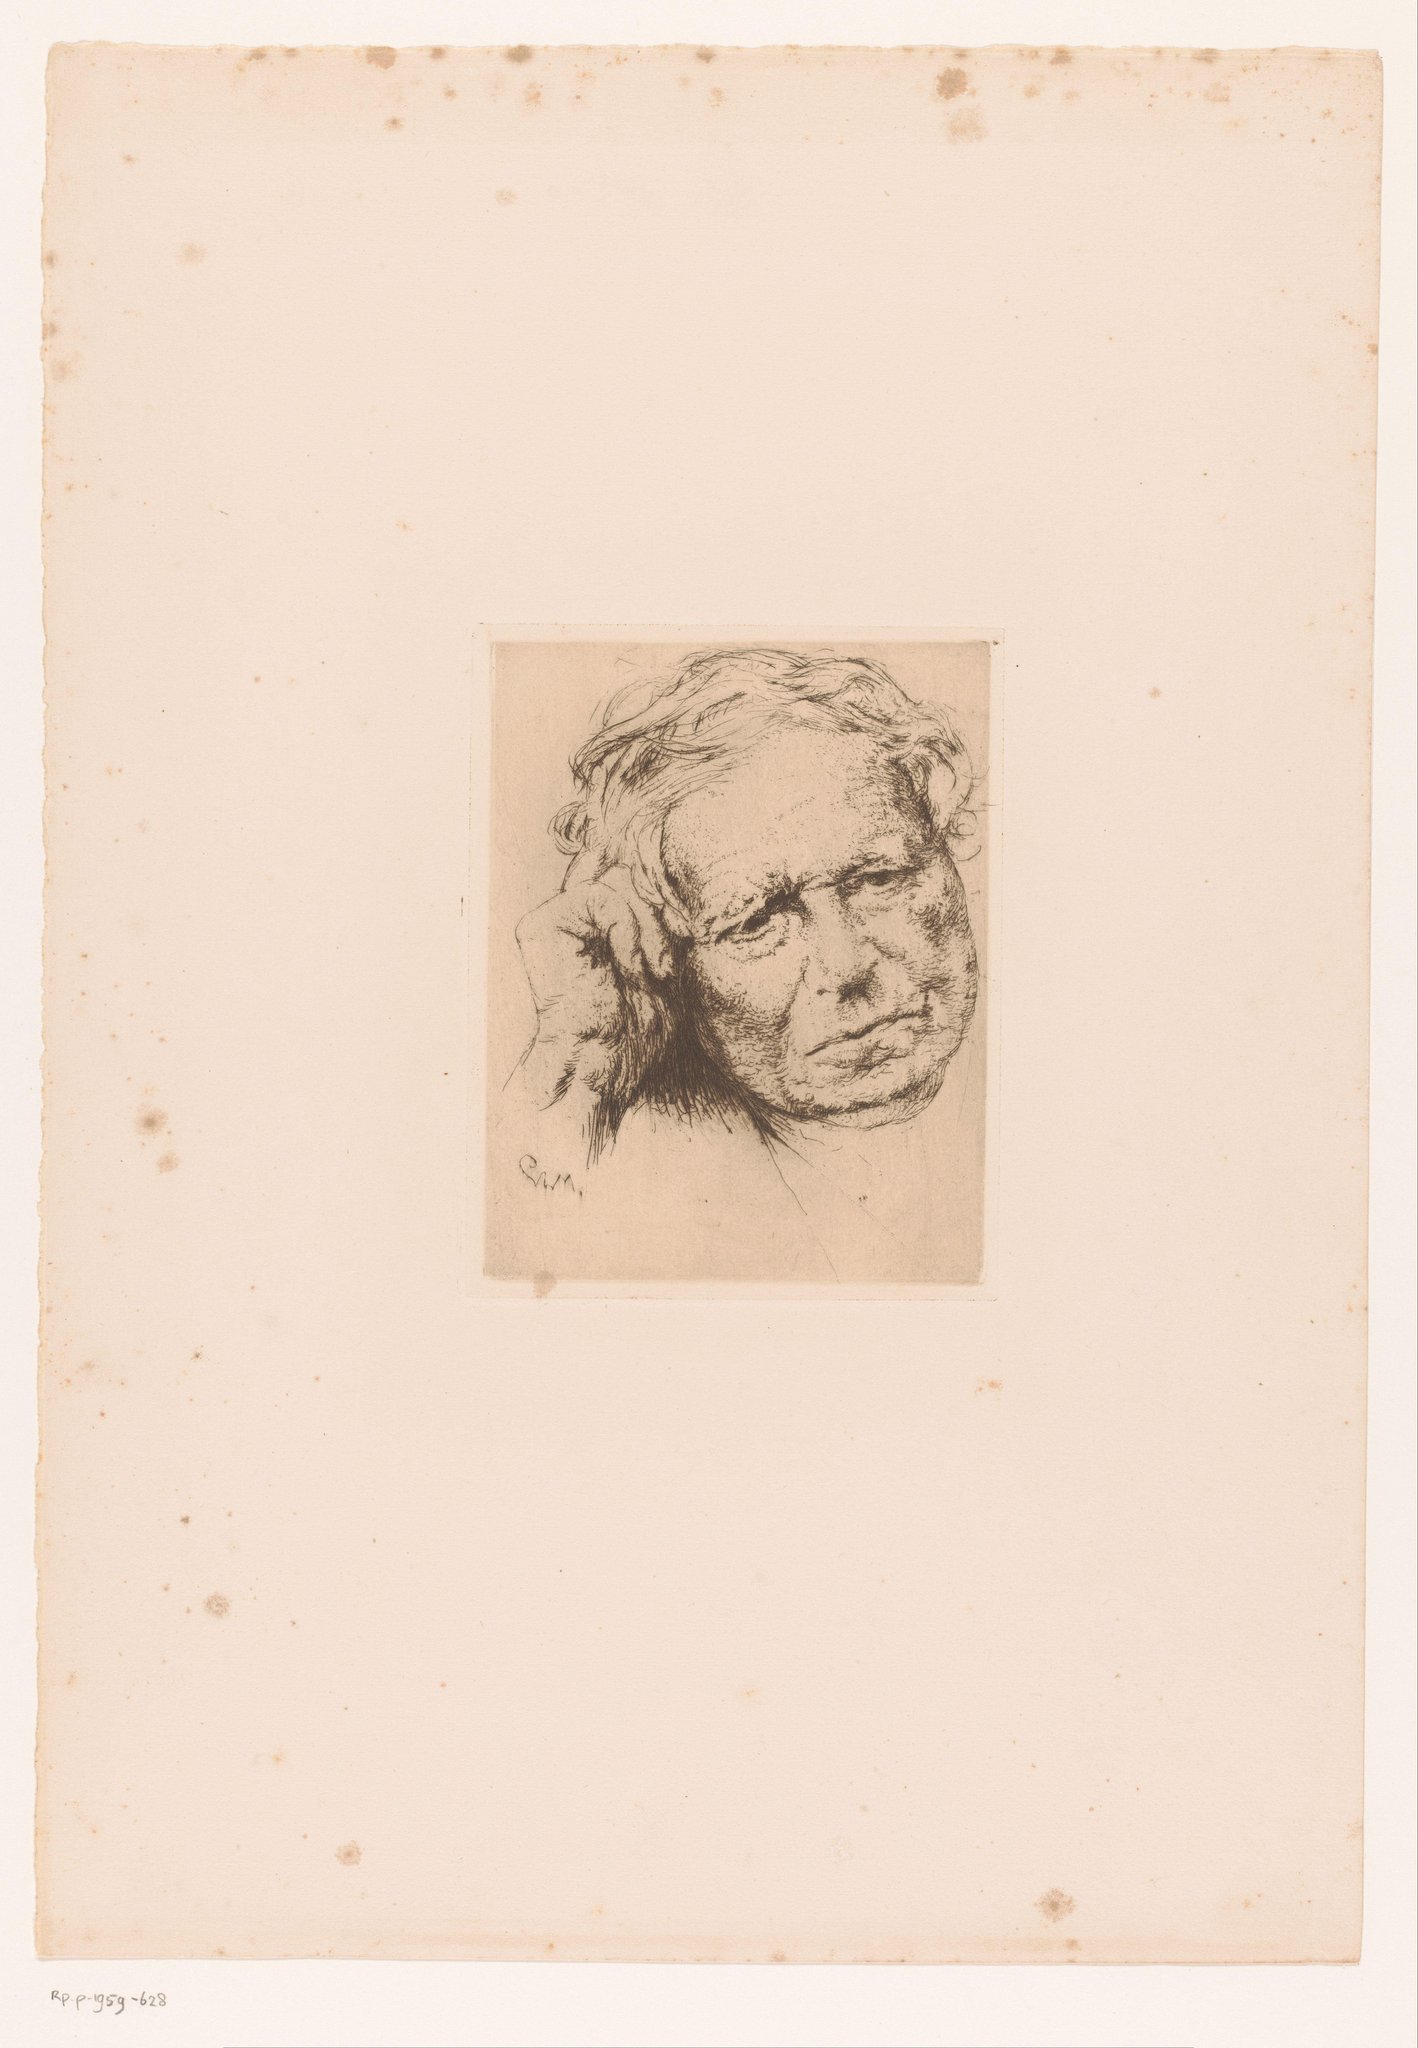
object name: print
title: Hoofd van een man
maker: charles mertens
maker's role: print maker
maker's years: 1865-1919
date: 1875-1919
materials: paper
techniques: etching, intaglio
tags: adult man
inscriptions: collector's mark: Lugt 2228, collector's mark: Lugt 2760